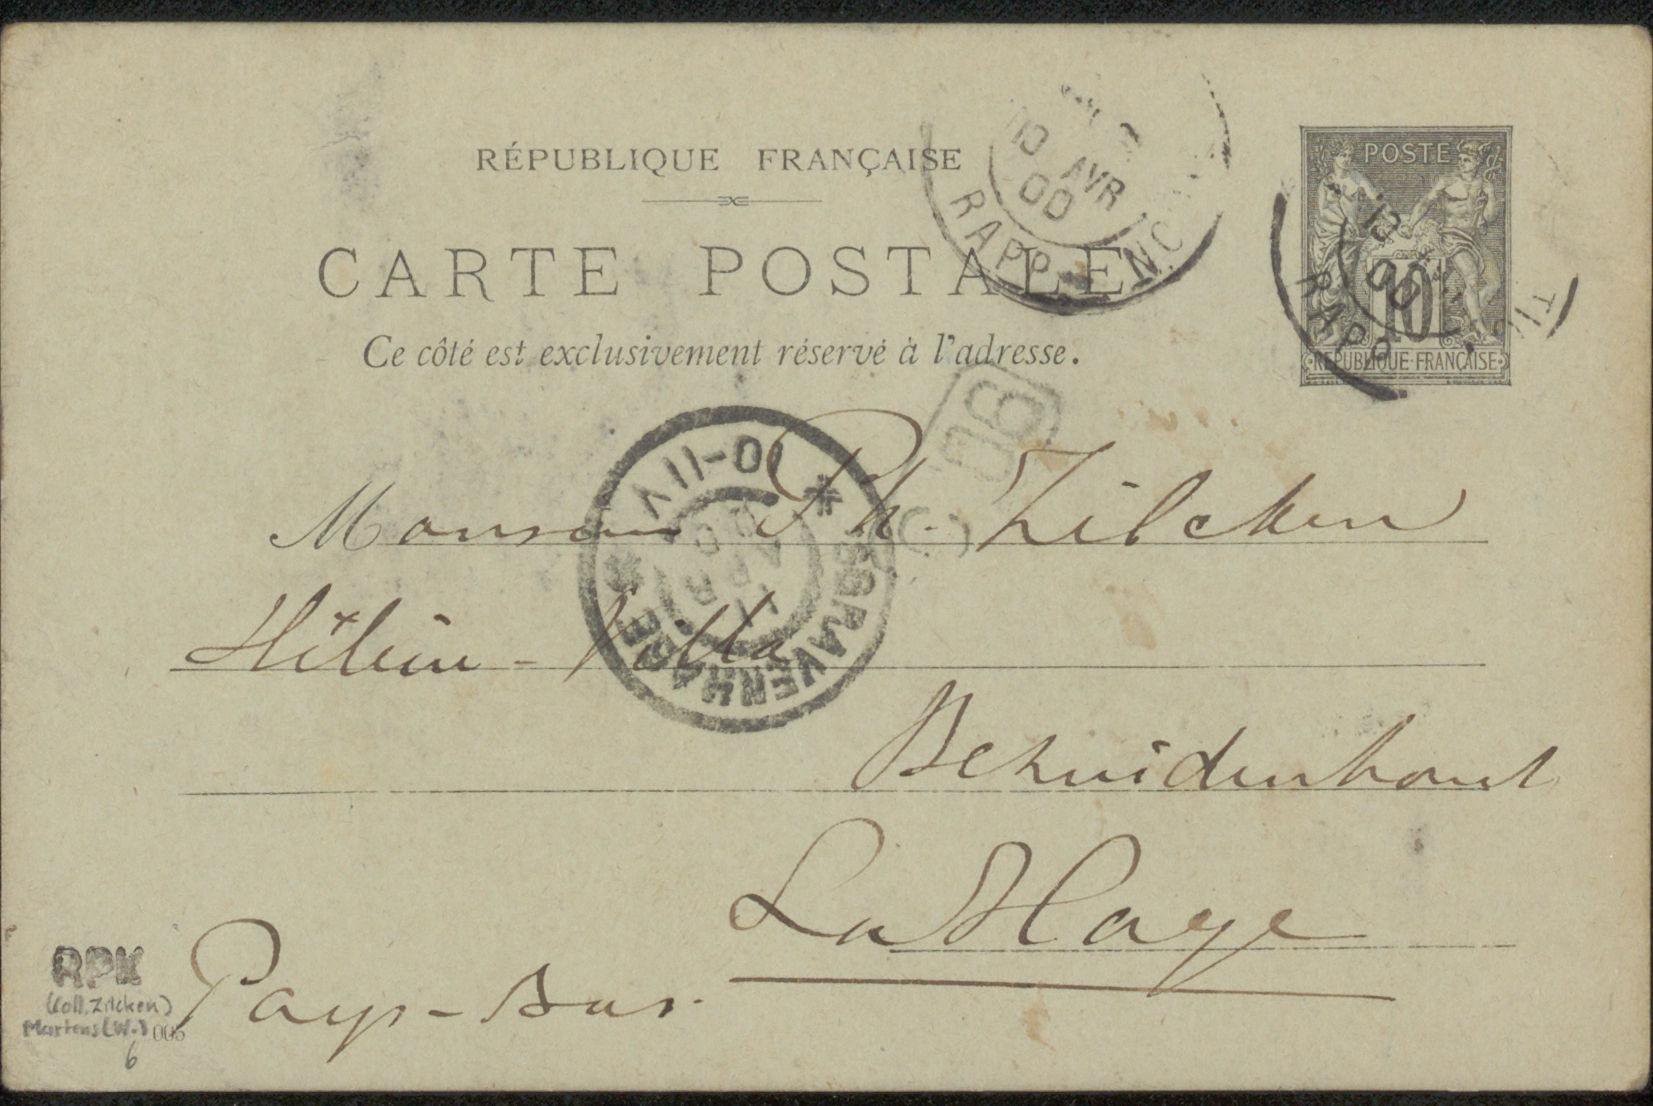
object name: postcard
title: Briefkaart aan Philip Zilcken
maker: willy martens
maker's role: painter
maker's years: 1856-1927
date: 1900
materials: cardboard, ink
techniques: pen, writing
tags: the hague, painter, draughtsman, philip zilcken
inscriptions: collector's mark: ‘RPK’